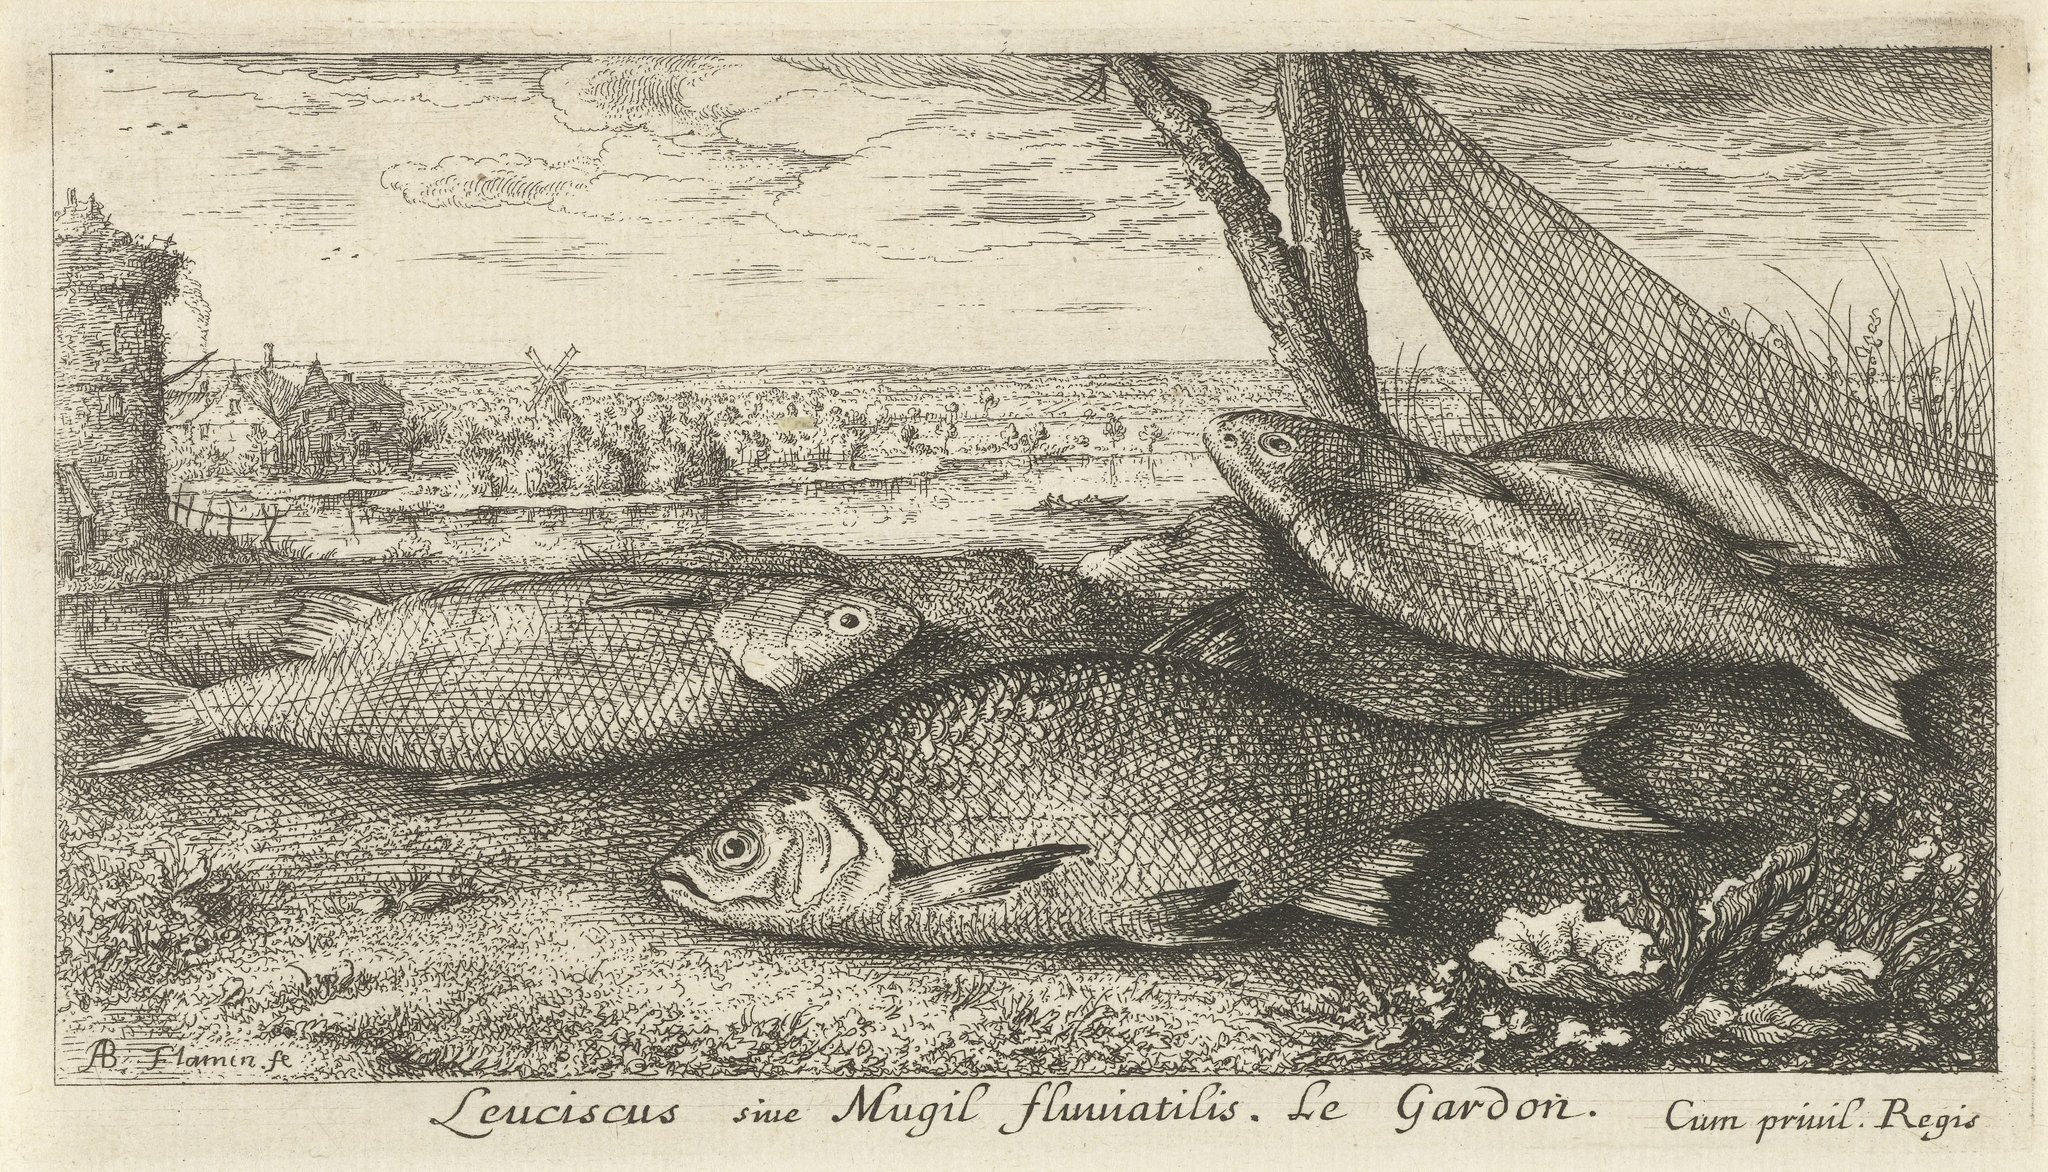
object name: print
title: Diverses Especes de Poissons d'eau douce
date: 1664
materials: paper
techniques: etching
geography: paris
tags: bony fishes: roach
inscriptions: collector's mark: Lugt 2228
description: Vier vissen op een rivieroever bij een visnet. Op de achtergrond een toren.